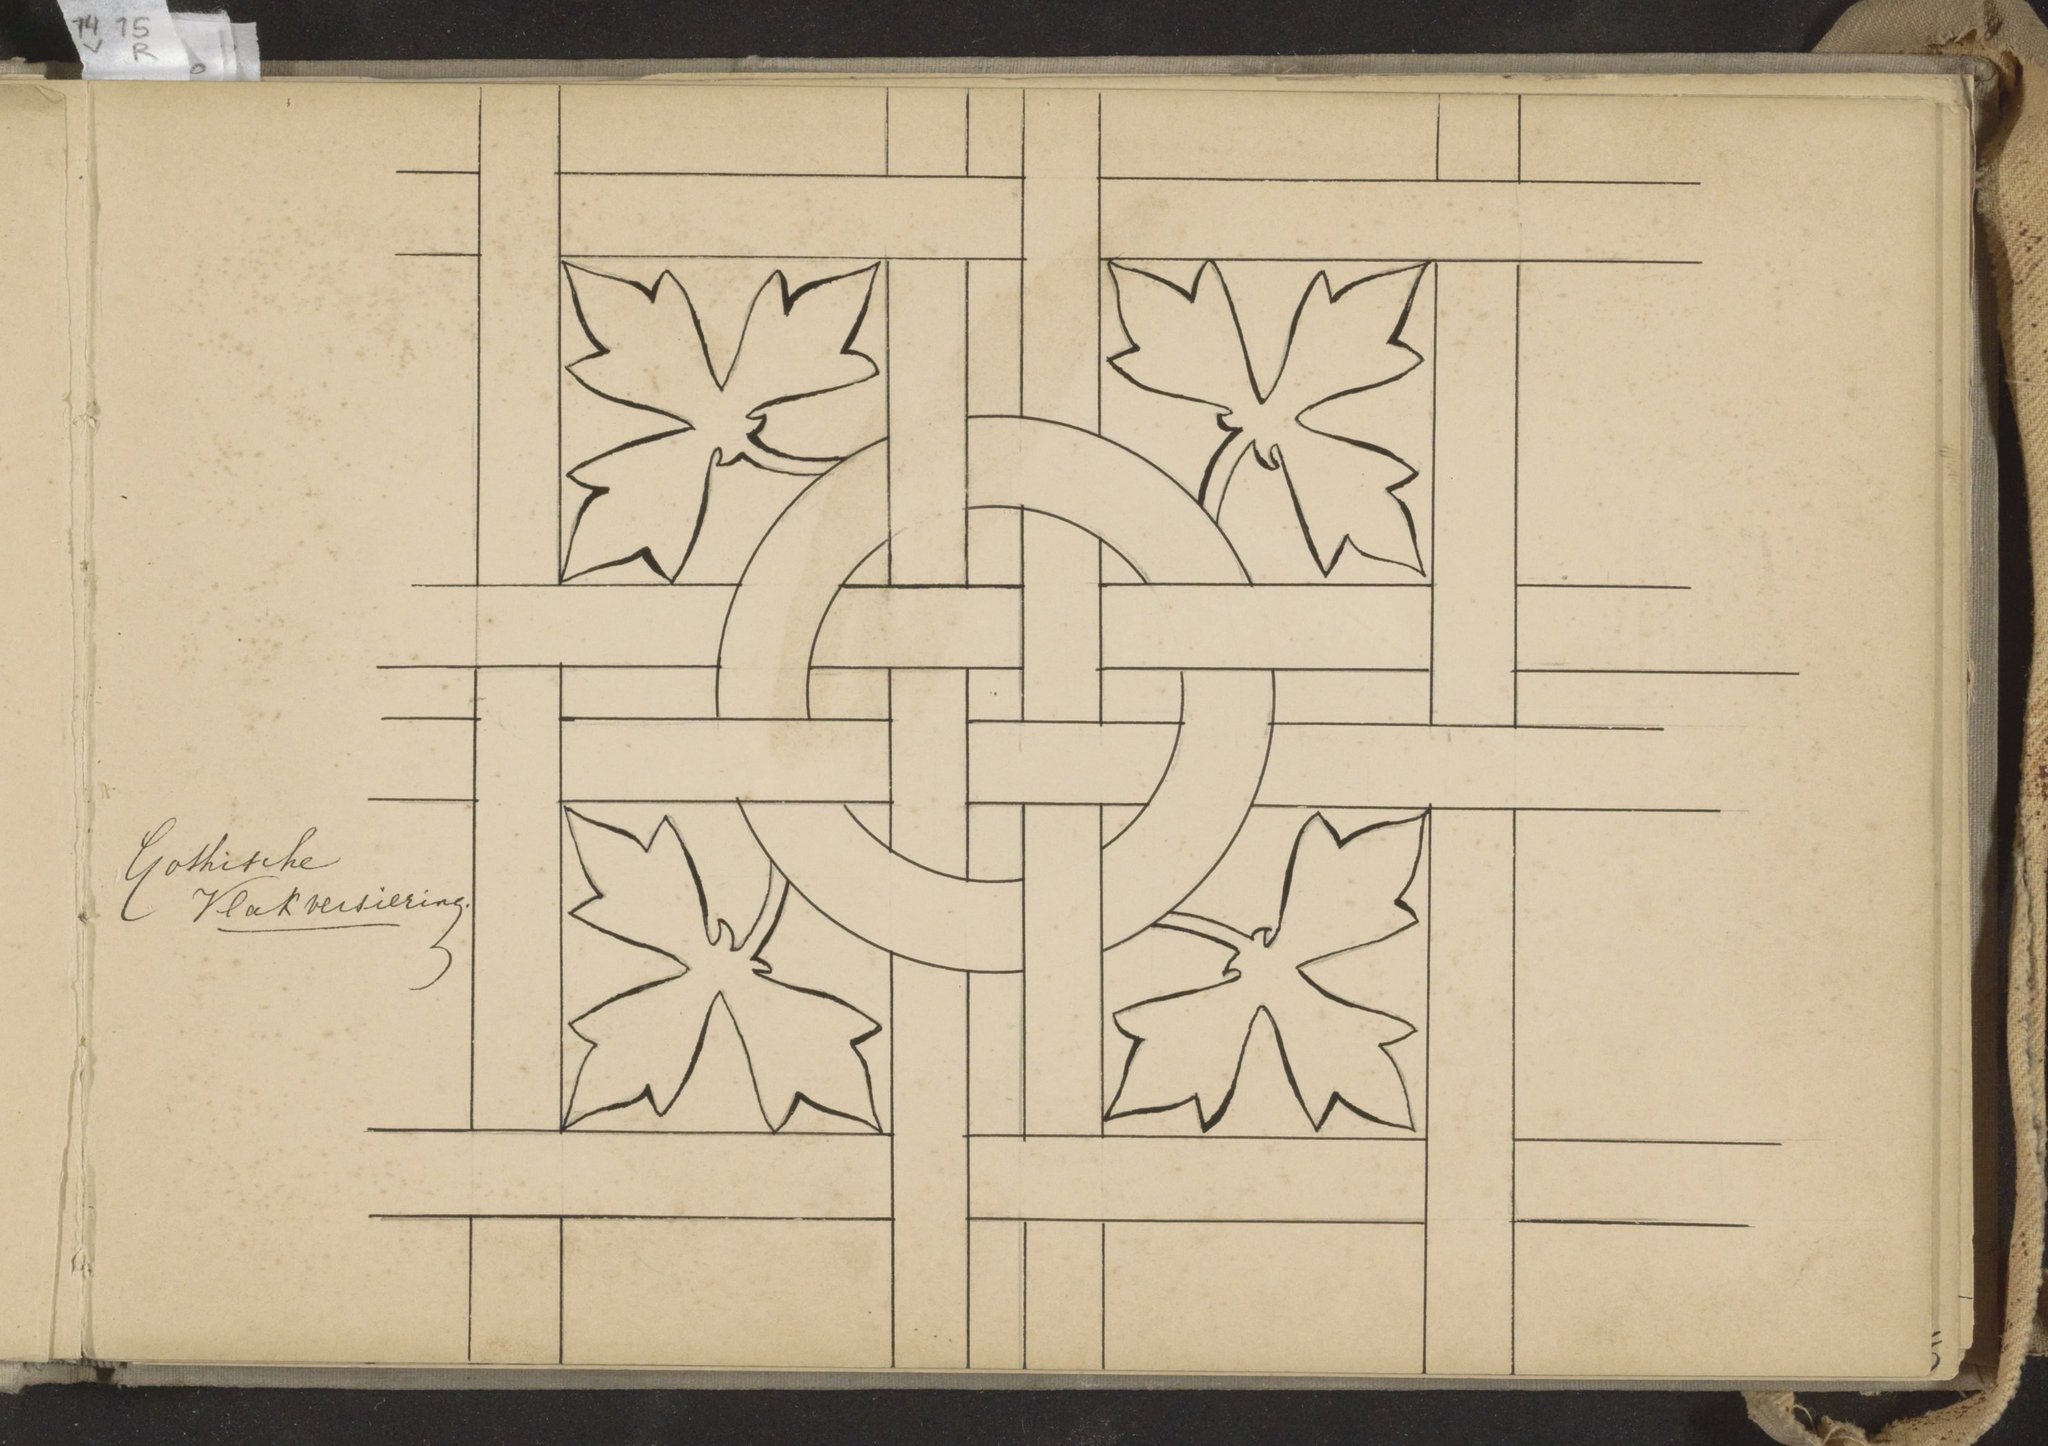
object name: sketchbook leaf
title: Gotische vlakversiering met vlechtwerk en eikenbladeren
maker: johanna van de kamer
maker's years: 1873-1922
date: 1890-1922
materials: ink, paper, pencil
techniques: pen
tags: interlace ~ ornament, foliage, tendrils, branches ~ ornament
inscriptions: annotation: ‘Gothische/ vlakversiering.’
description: Blad 13 recto uit een schetsboek met 43 bladen.